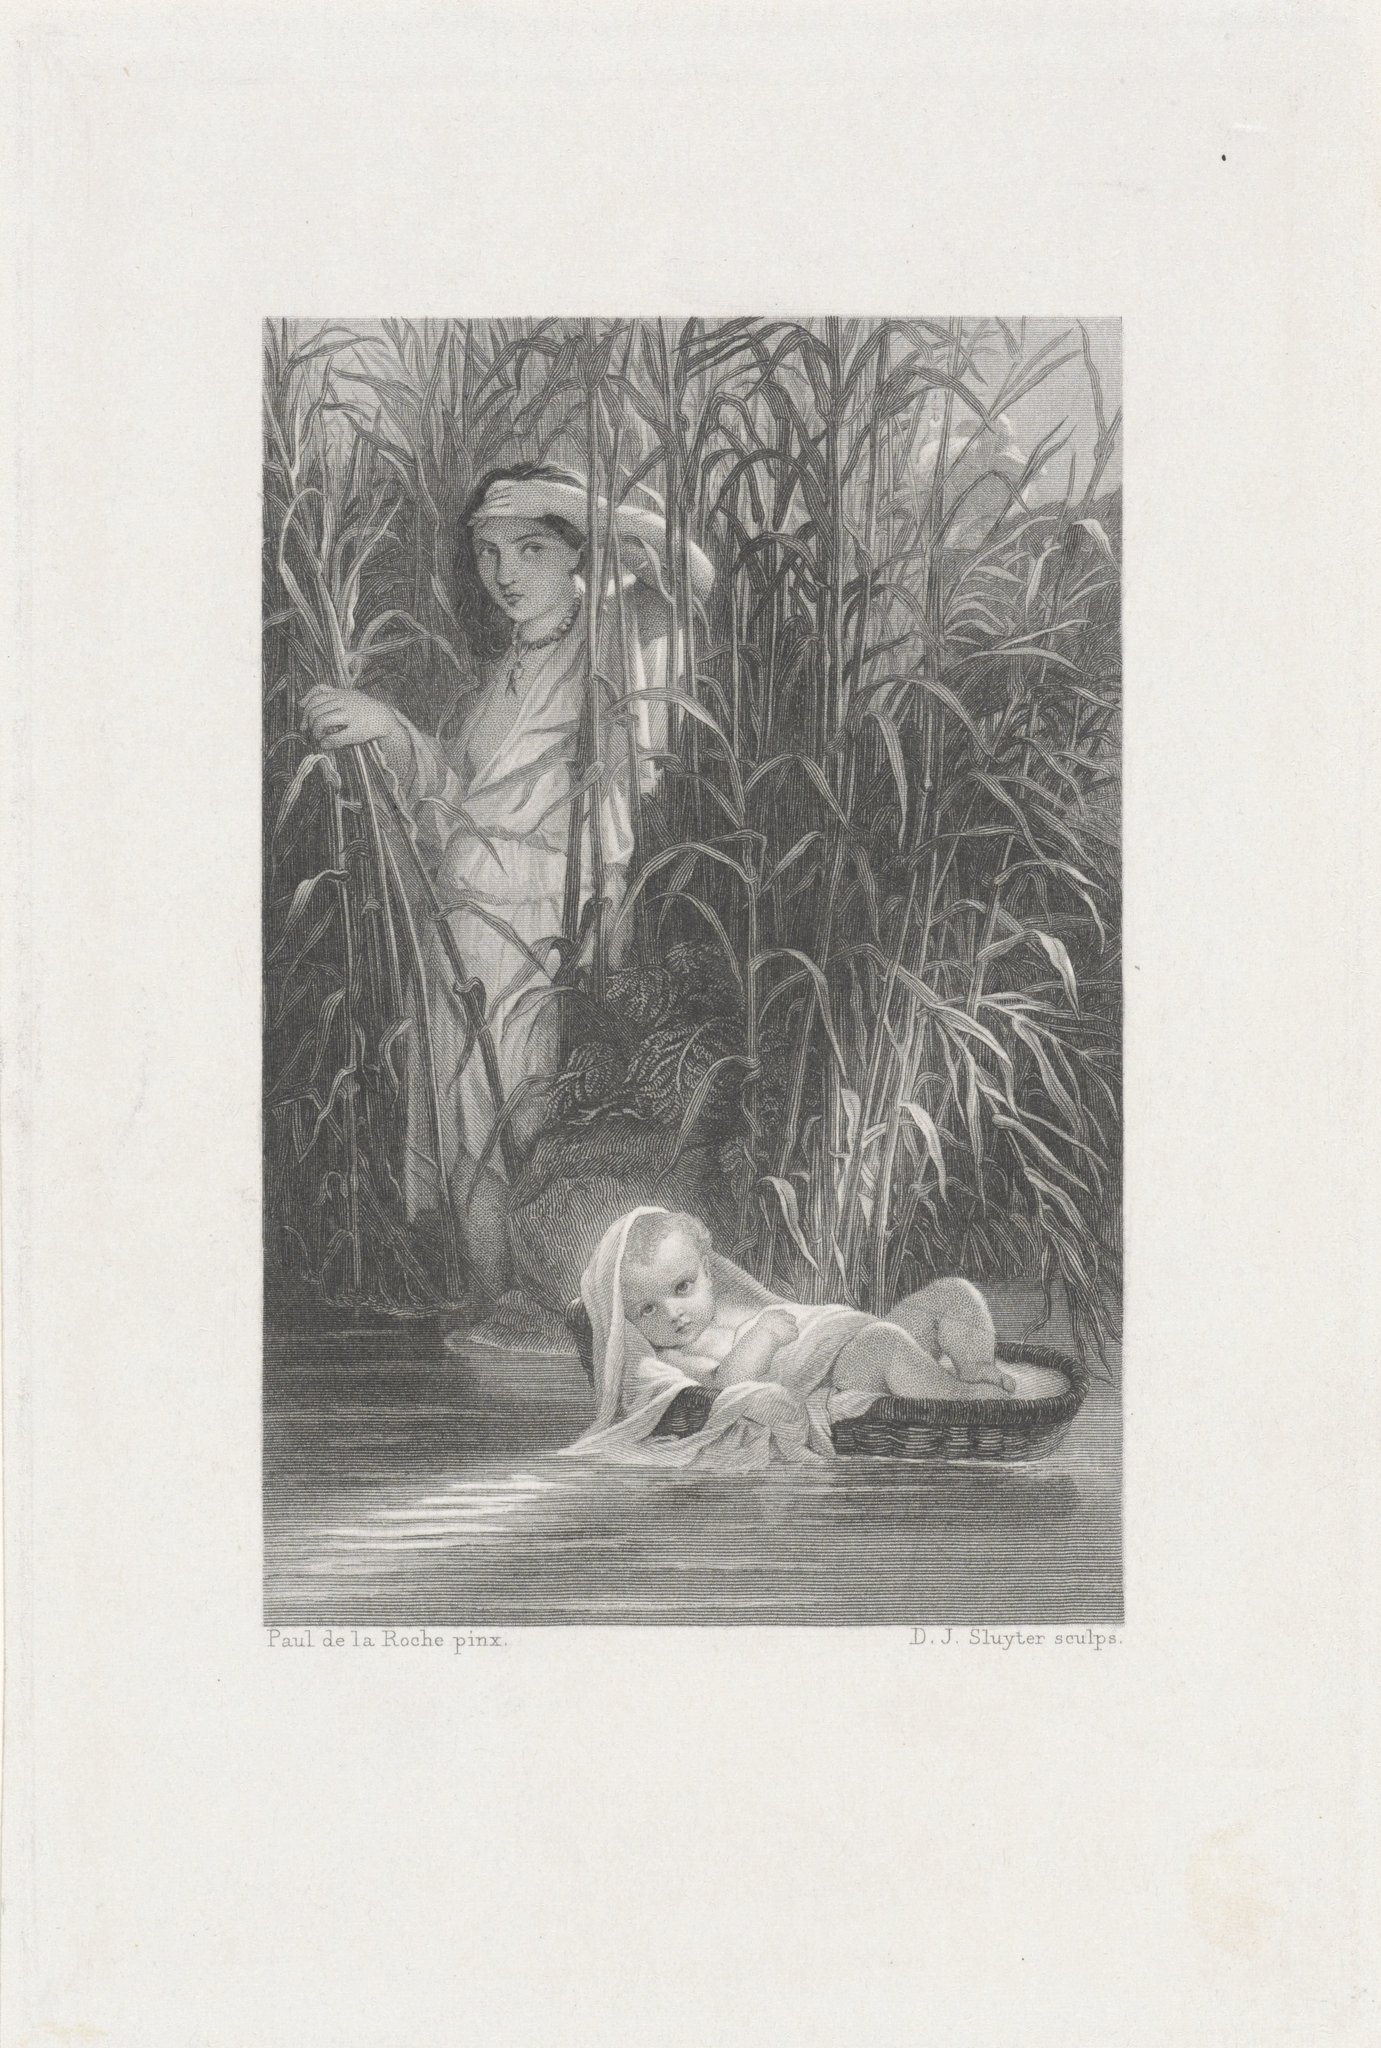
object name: print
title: Farao's dochter vindt Mozes in het biezen mandje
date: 1826-1886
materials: paper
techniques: aquatint, engraving, etching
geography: amsterdam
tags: the finding of moses: pharaoh's daughter comes to bathe with her maidens in the river and discovers the child floating on the water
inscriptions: collector's mark: Lugt 2228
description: De dochter van de farao vindt Mozes in de biezen mand tussen het riet aan de oever van de rivier de Nijl (Ex. 2: 5).